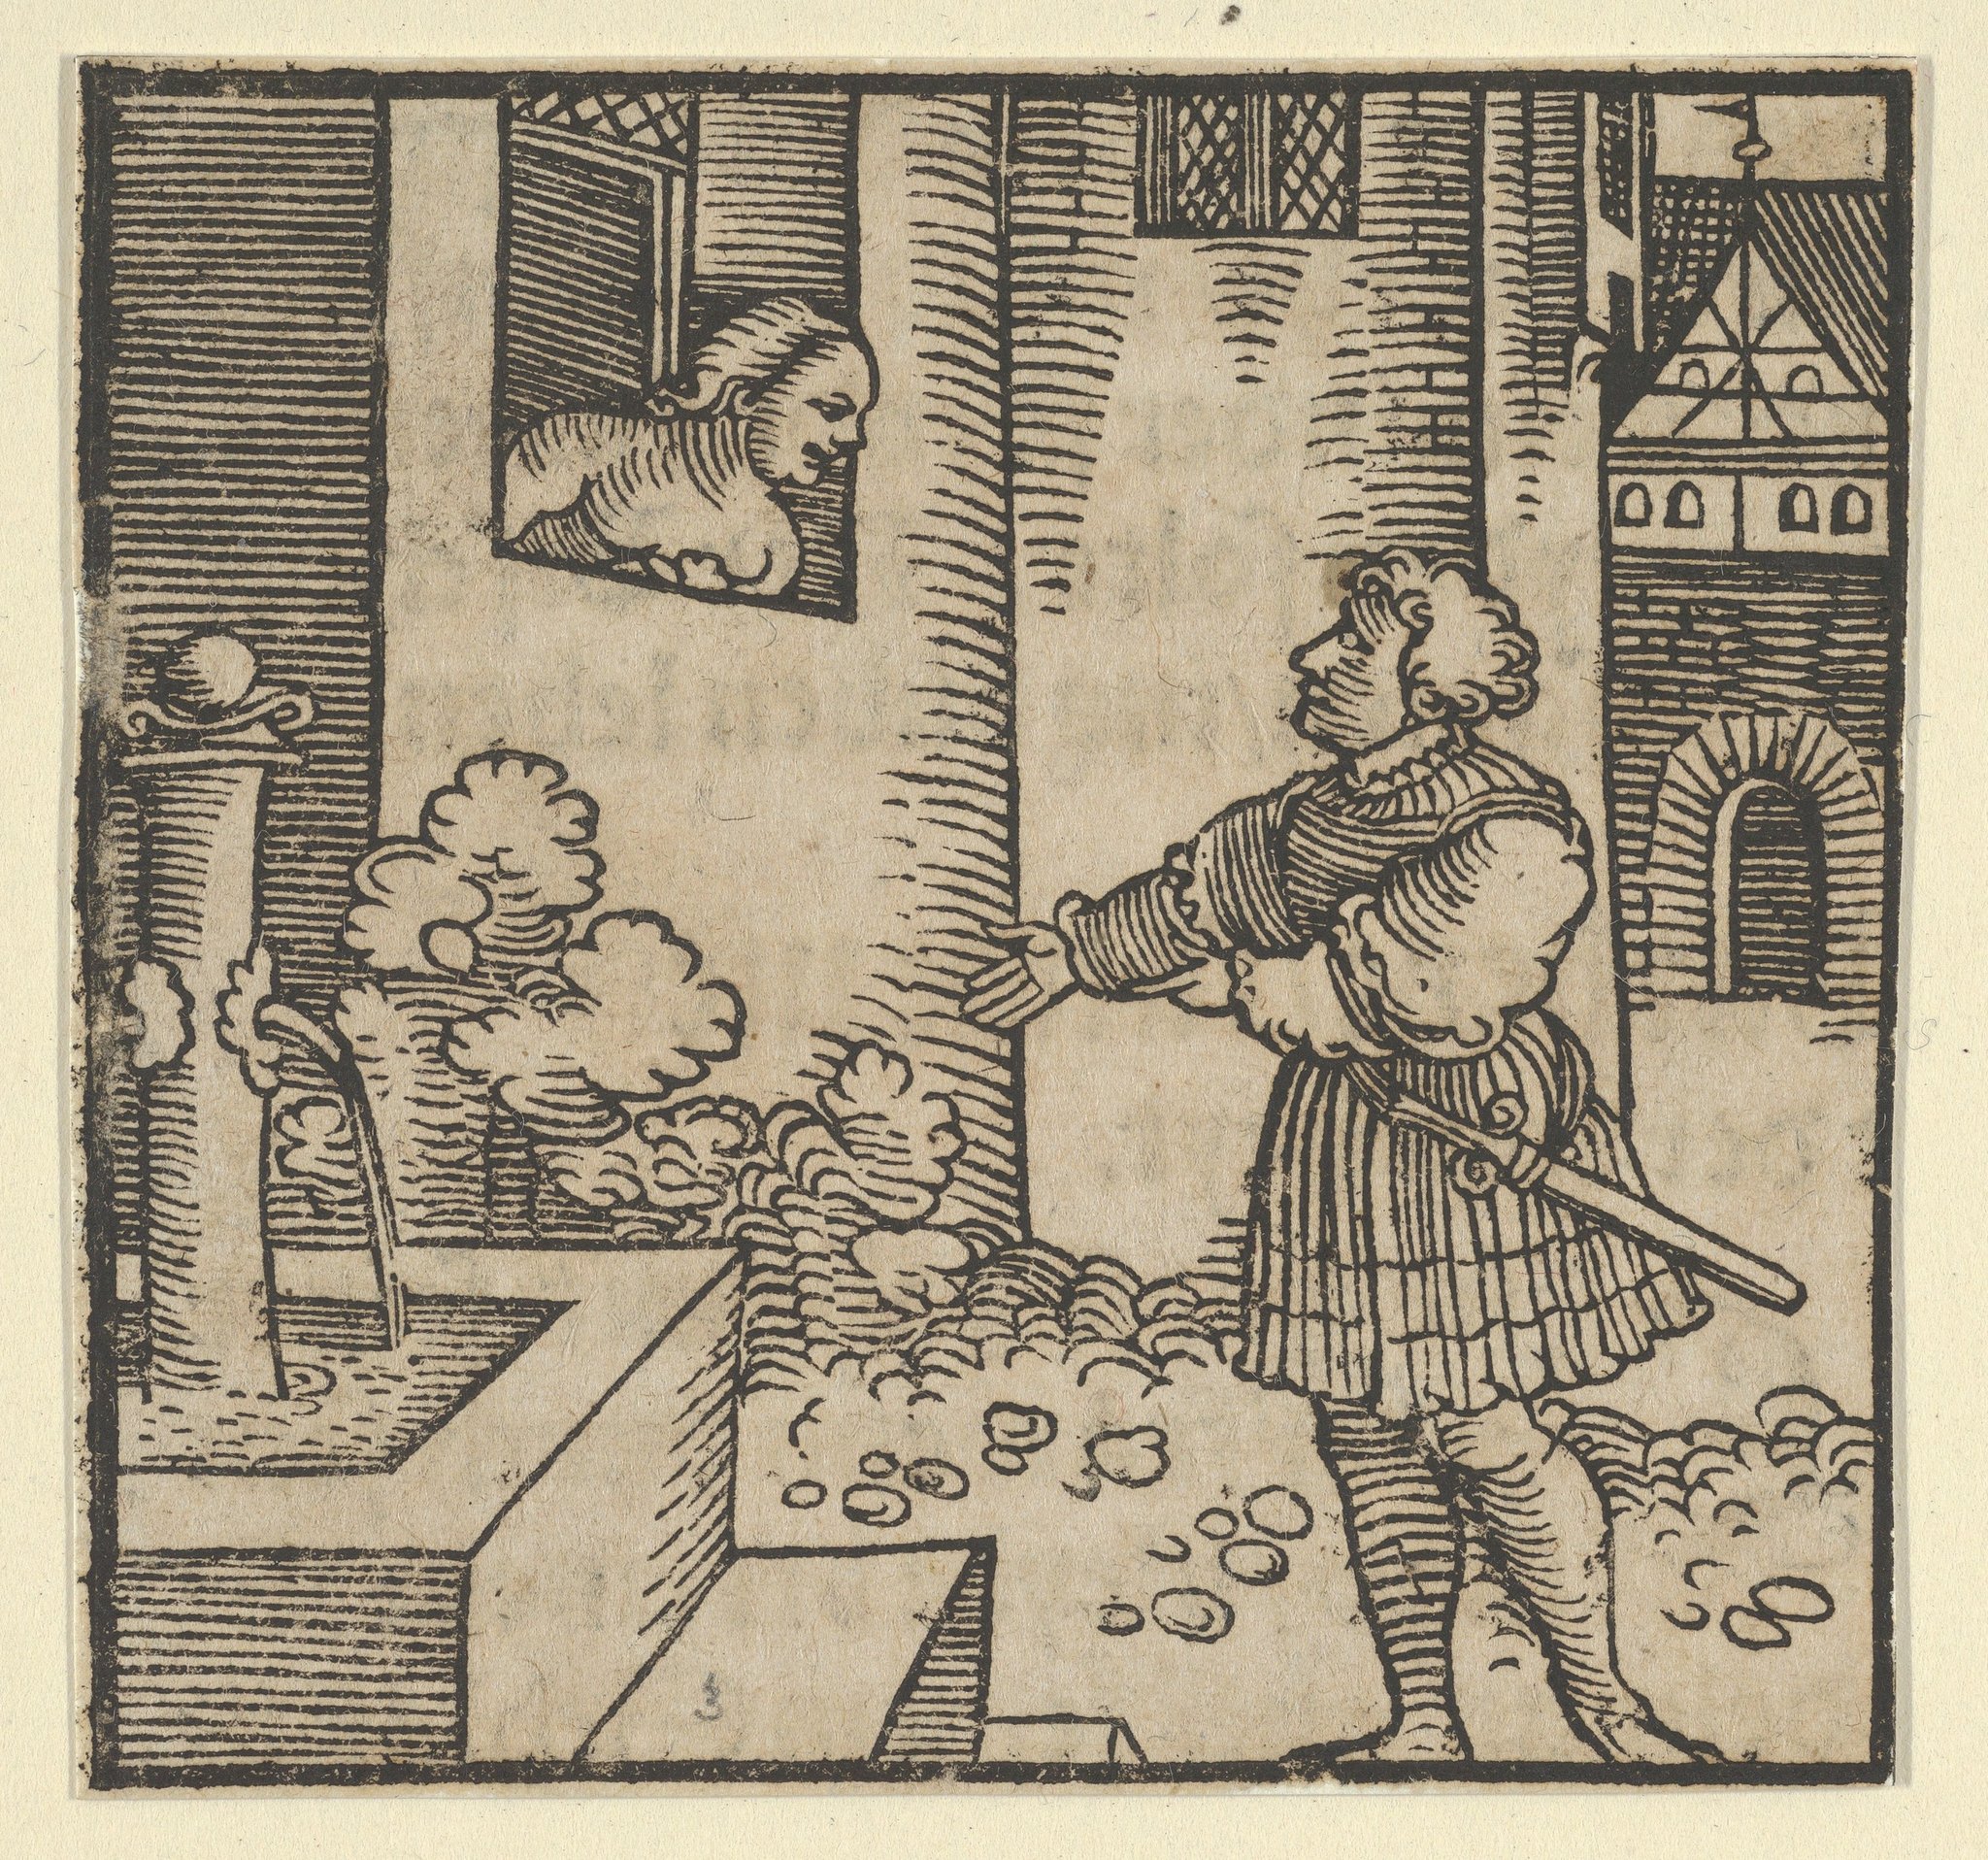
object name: print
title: Ghita Locking out her Husband Tofano, from The Decameron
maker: hans schäufelein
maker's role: artist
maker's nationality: german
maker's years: 1480-1540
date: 1534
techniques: woodcut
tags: windows,men,women